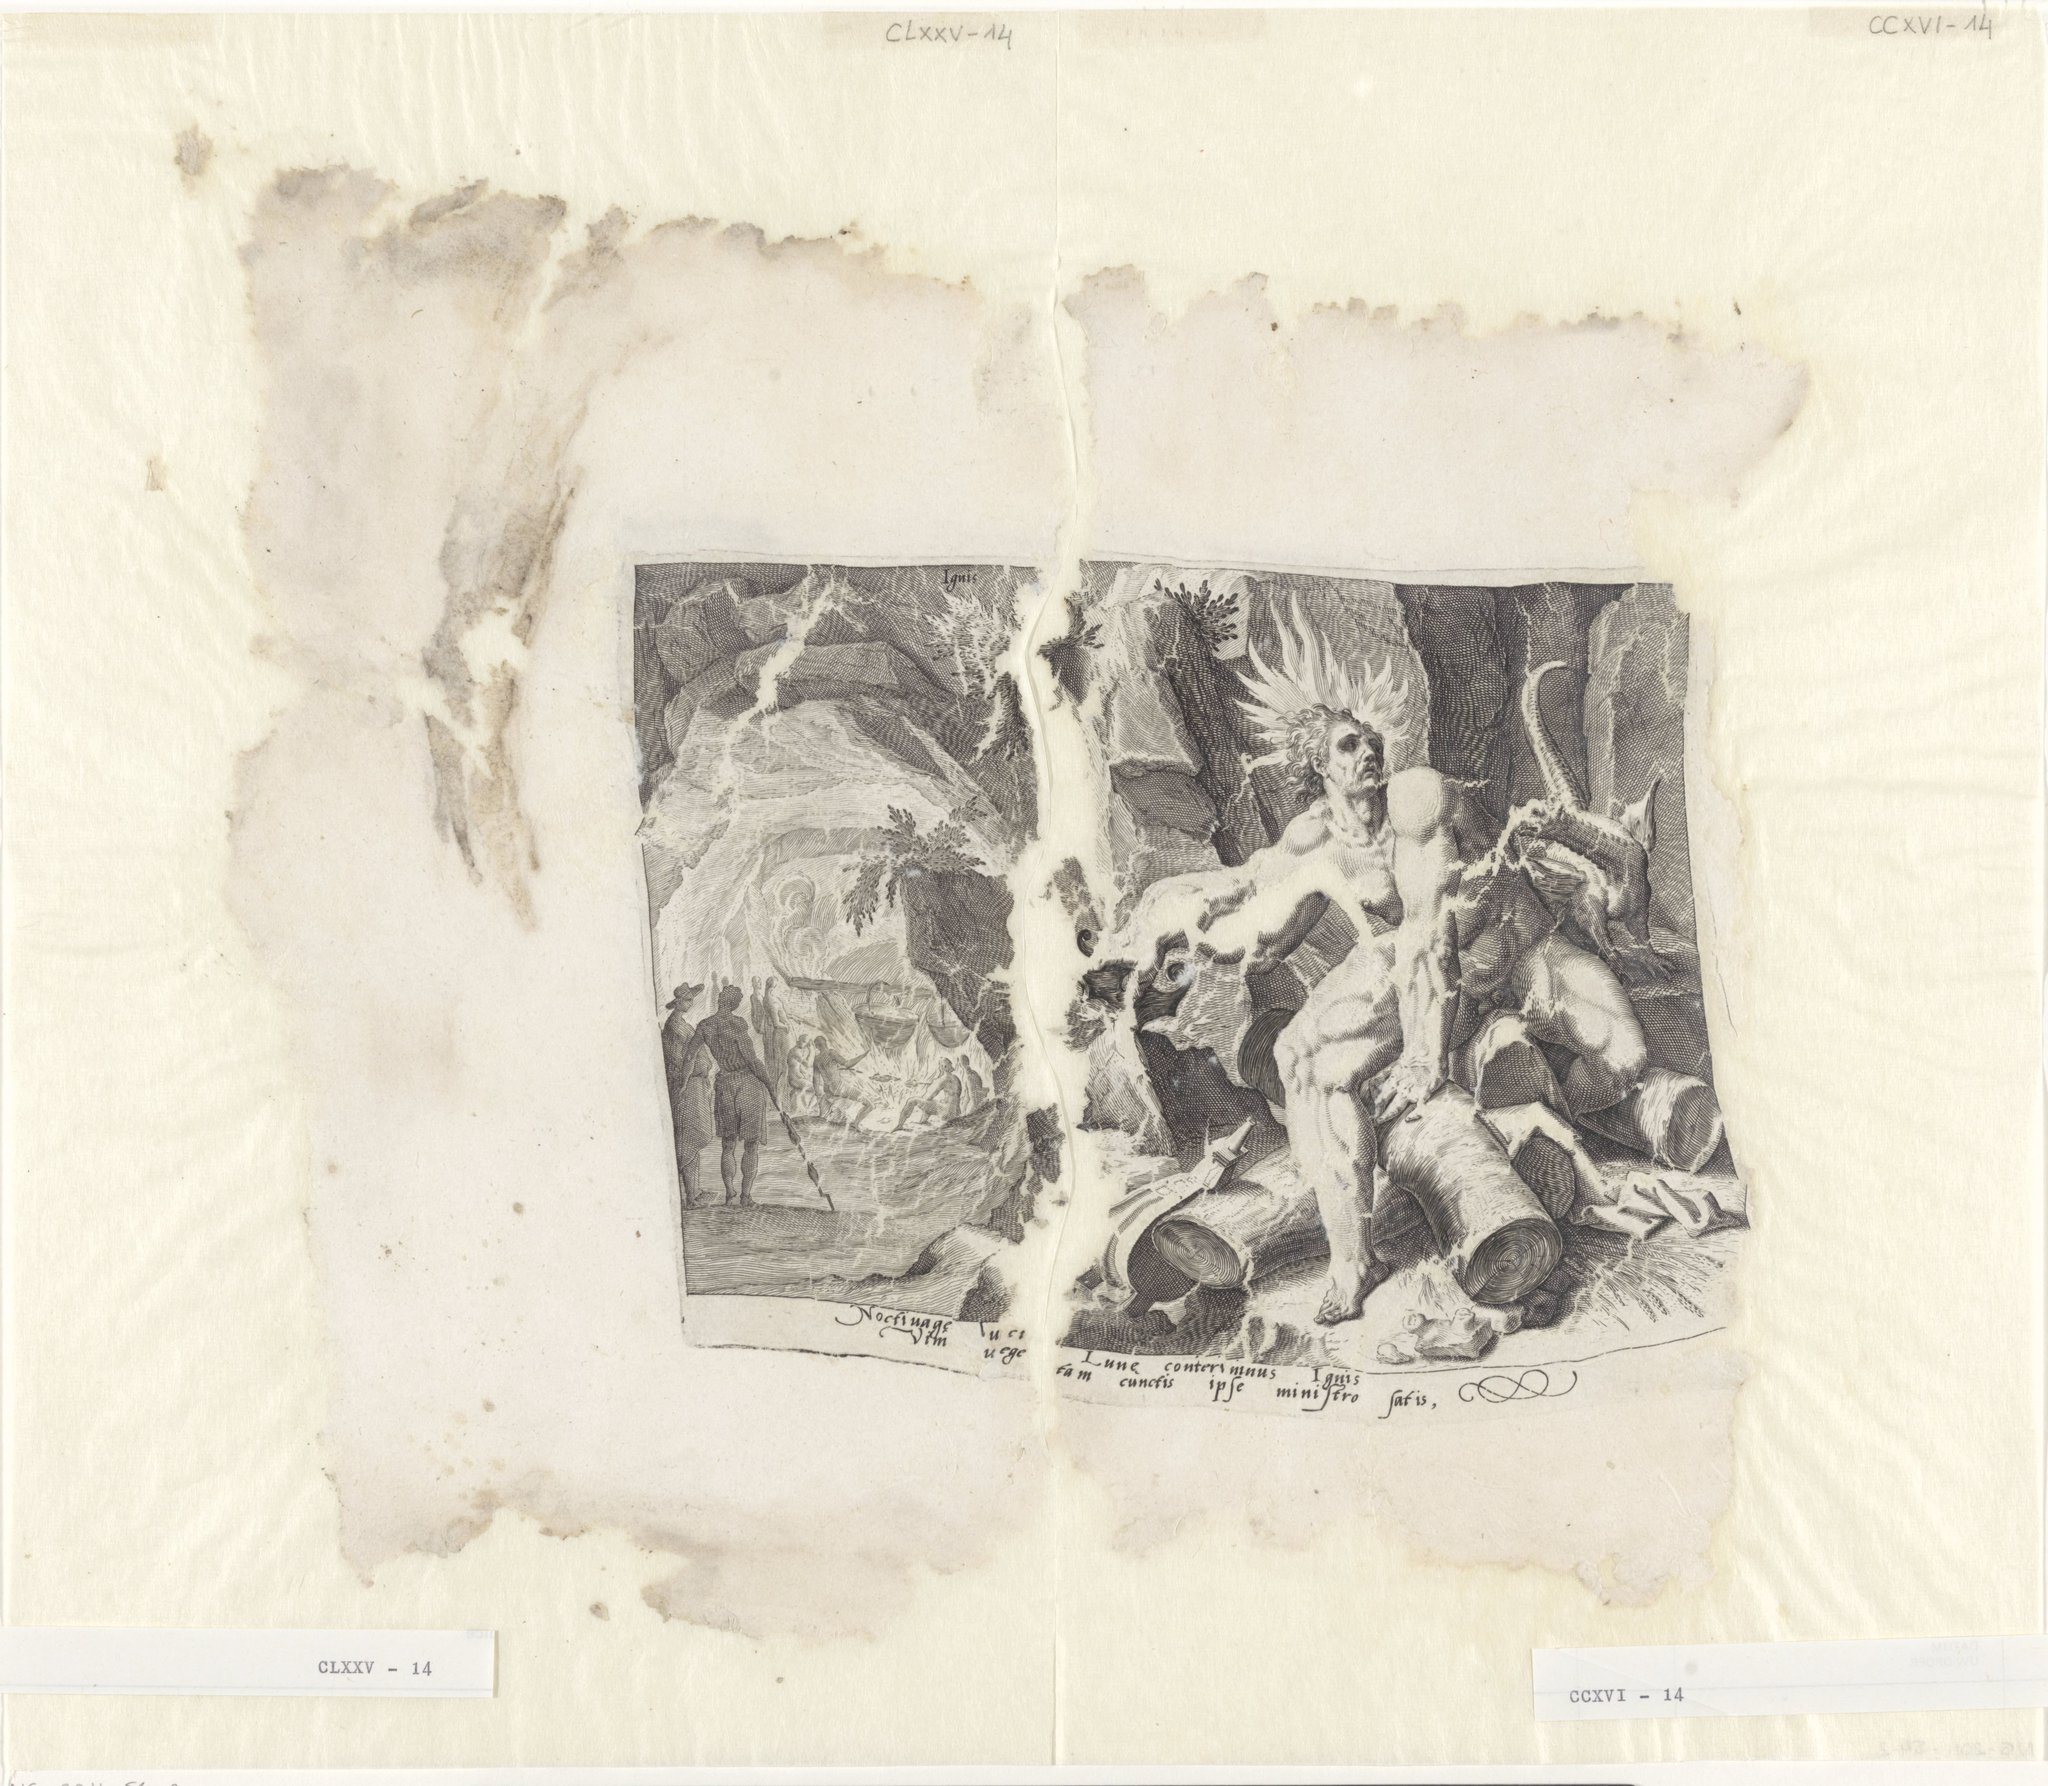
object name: print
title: Vuur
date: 1580-1596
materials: paper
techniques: engraving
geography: amsterdam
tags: fire (one of the four elements)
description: De prenten in de Nova Zembla collectie zijn tijdens een expeditie van Willem Barendsz en Jacob van Heemskerk in 1596-1597 noodgedwongen in het winterkamp, het ‘Behouden Huis’, op het eiland achtergelaten. De prenten waren in één of meerdere stapels als handelswaar meegenomen vanuit Amsterdam. Bijna drie eeuwen later, in 1871, keerde de Noor Elling Carlsen terug naar Nova Zembla en vond daar de restanten van het ‘Behouden Huis, inclusief een groot deel van de inventaris. Een deel van de prenten, in de vorm van aaneengekoekte kluiten, werd toen ook teruggevonden. De papierkluiten waren soms op meerdere plekken gebroken. Tussen 1975-1979 zijn de prenten van elkaar gescheiden. Dit leverde in totaal ca. 1000 fragmenten van ca. 400 afdrukken van ca. 150 verschillende prenten op. Voor zover mogelijk zijn de fragmenten samengevoegd en zijn de prenten gereconstrueerd.